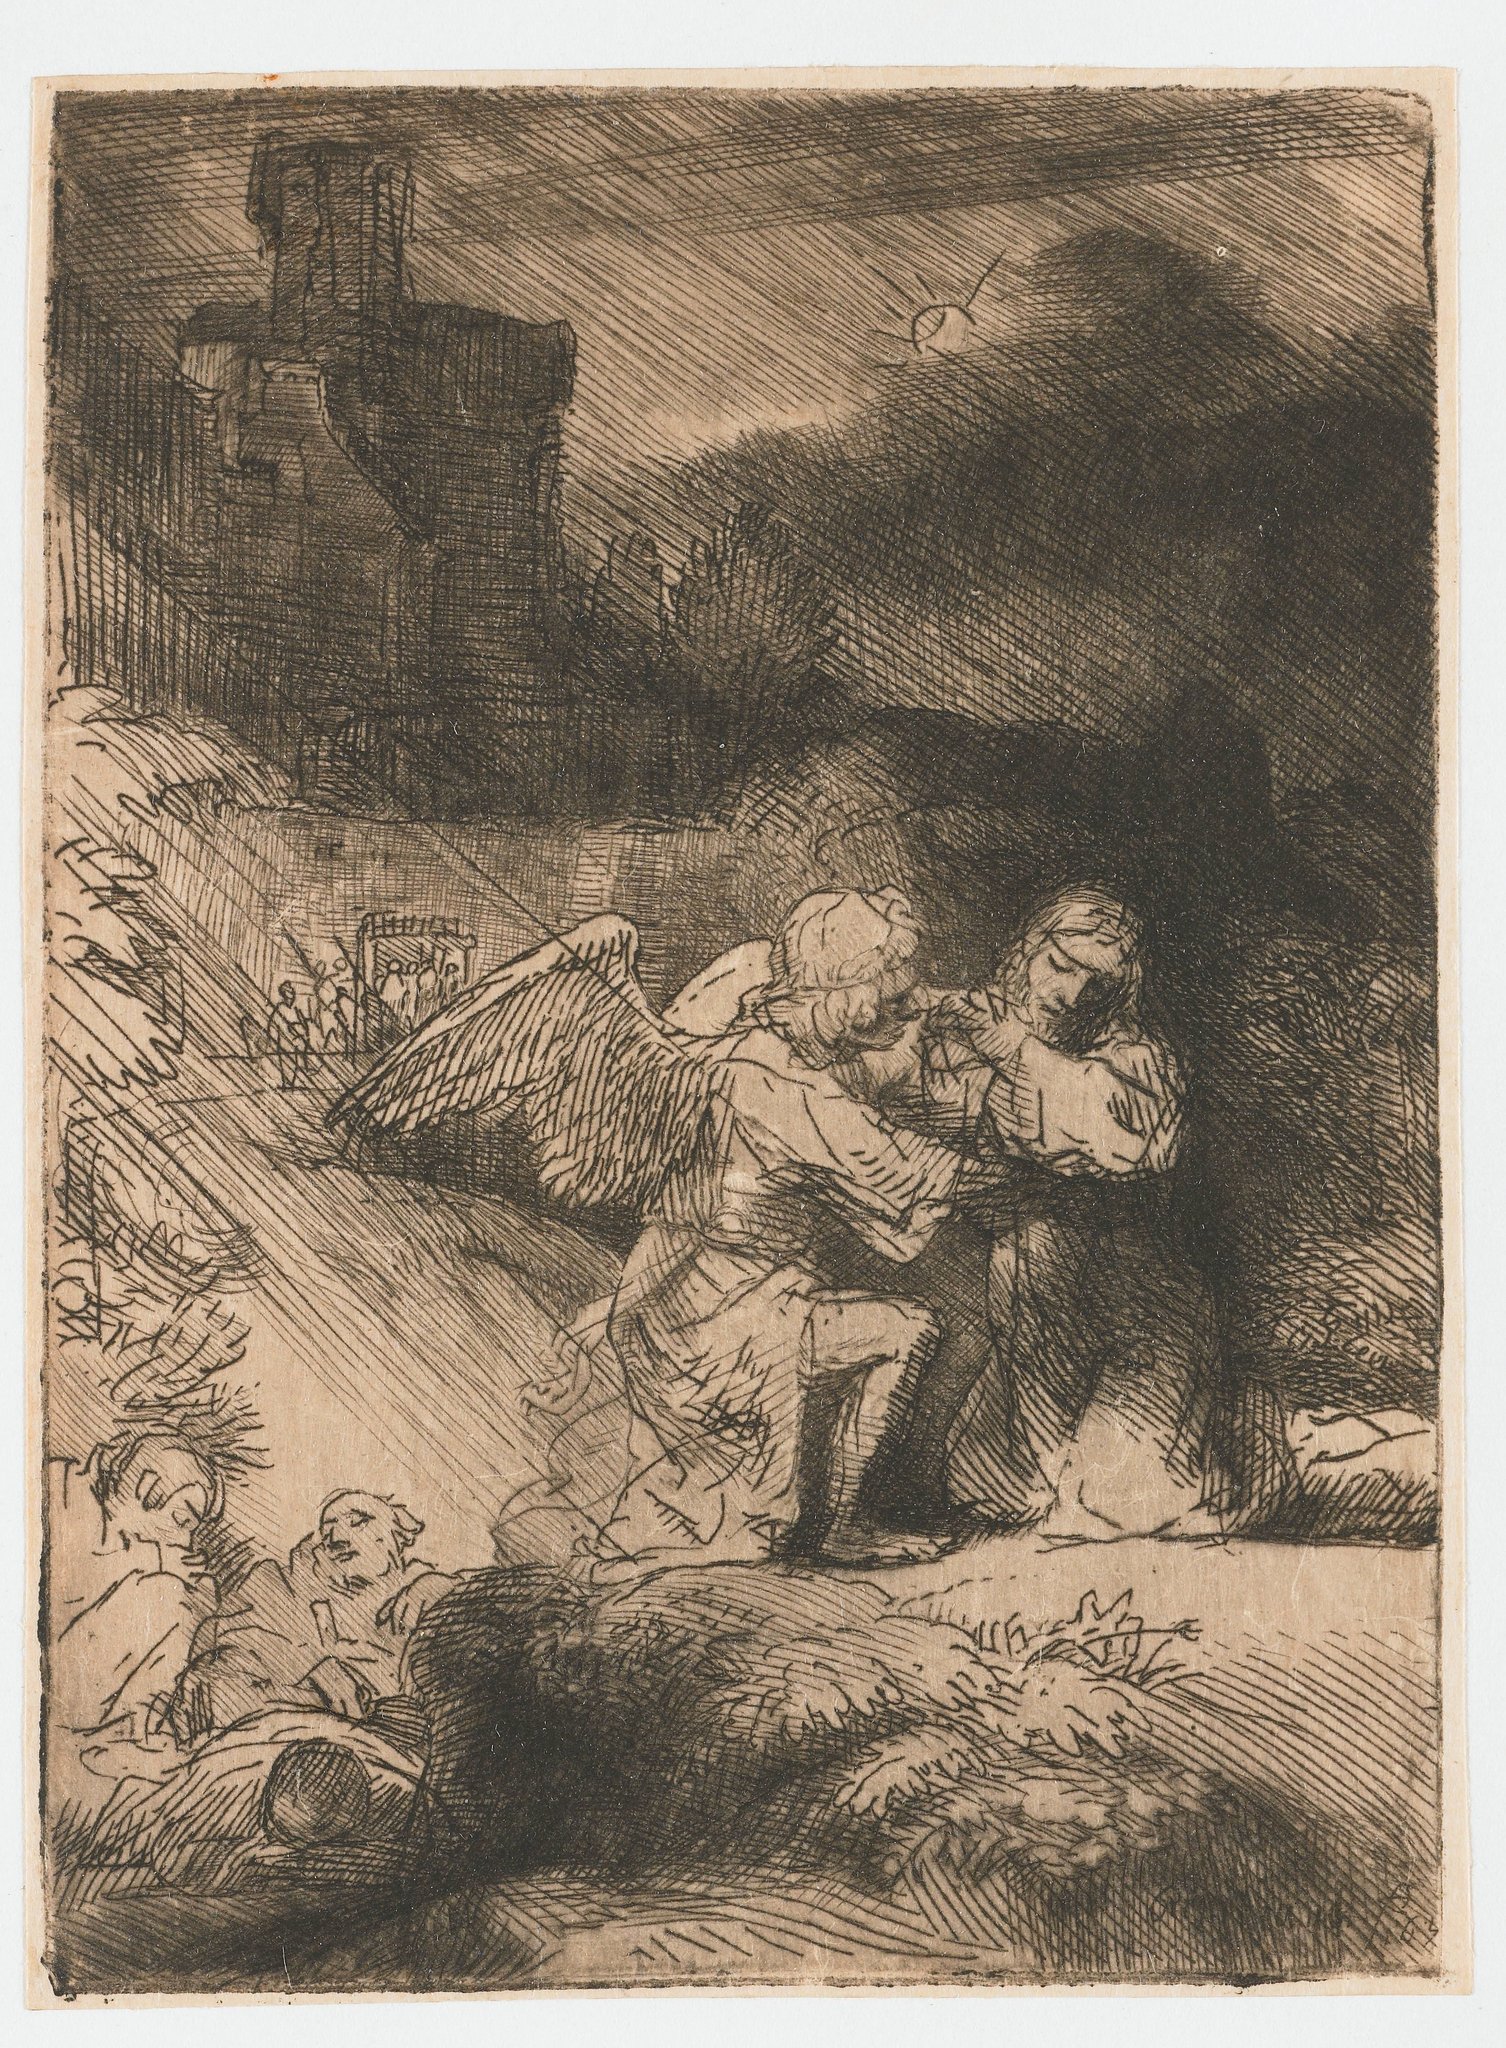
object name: print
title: The agony in the garden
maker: rembrandt van rijn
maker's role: draughtsman, painter, print maker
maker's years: 1606-1669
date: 1652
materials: paper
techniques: drypoint, etching, intaglio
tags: gethsemane, mount of olives, 'oelberg' (matthew 26:36-56; mark 14:32-52; luke 22:39-53; john 18:1-12)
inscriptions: collector's mark: Lugt 240, signature and date: ‘Rembrandt f. 165-’